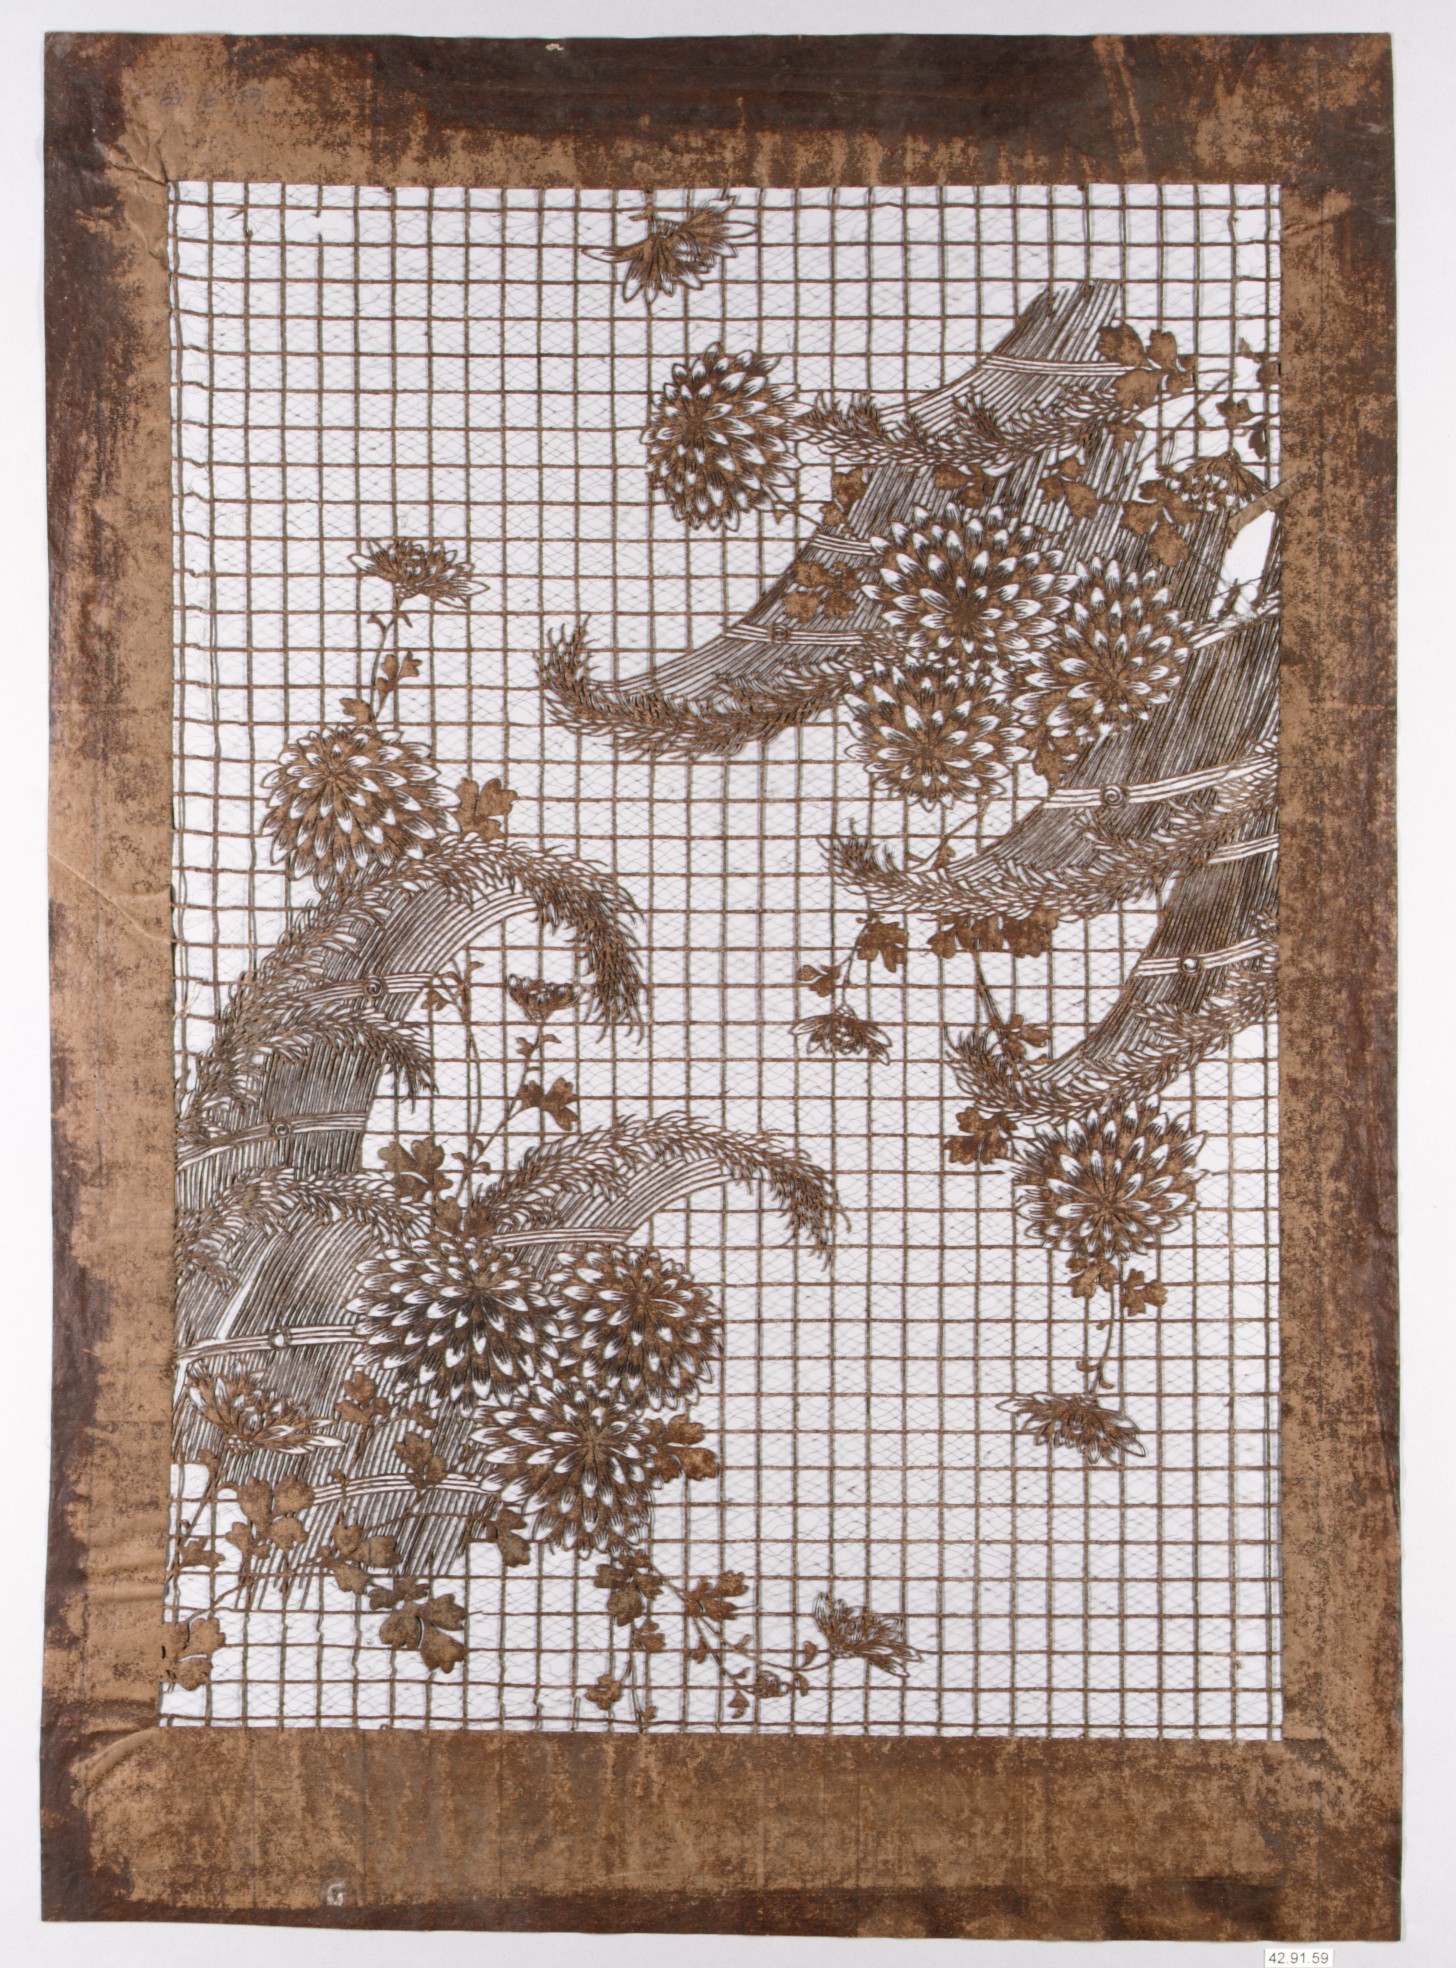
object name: stencil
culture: japanese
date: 1801-1900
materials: paper, silk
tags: flowers